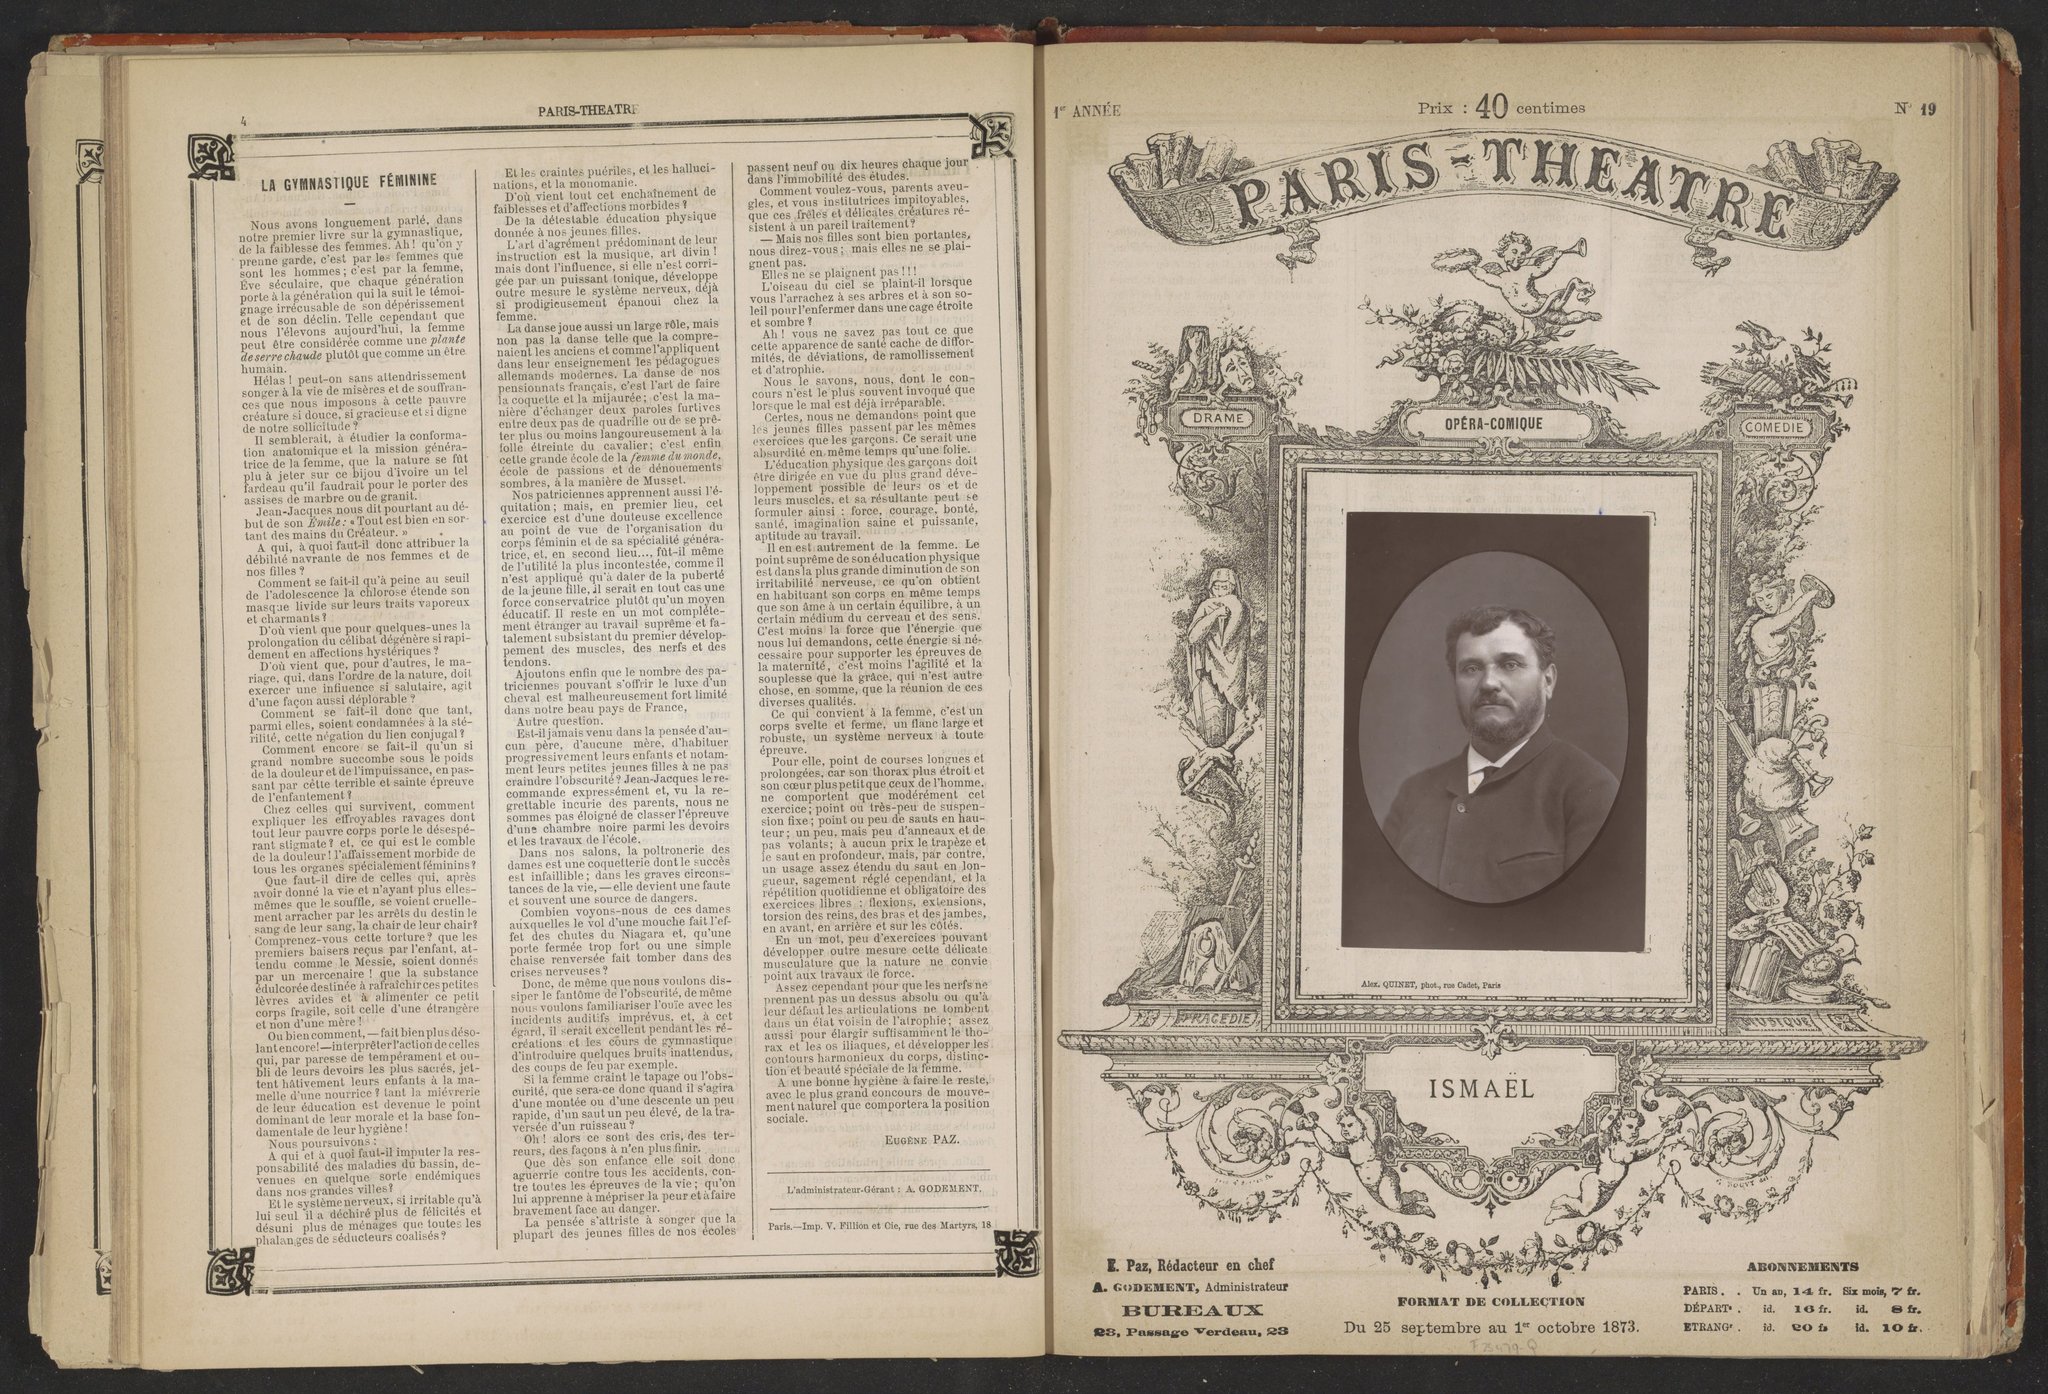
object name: photomechanical print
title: Ismaël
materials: paper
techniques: woodburytype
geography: france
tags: portrait of opera-singer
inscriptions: name: ‘Alex. Quinet, phot., rue Cadet, Paris’, number: ‘No 19’, inscription: ‘Du 25 Septembre au 1er Octobre 1873’